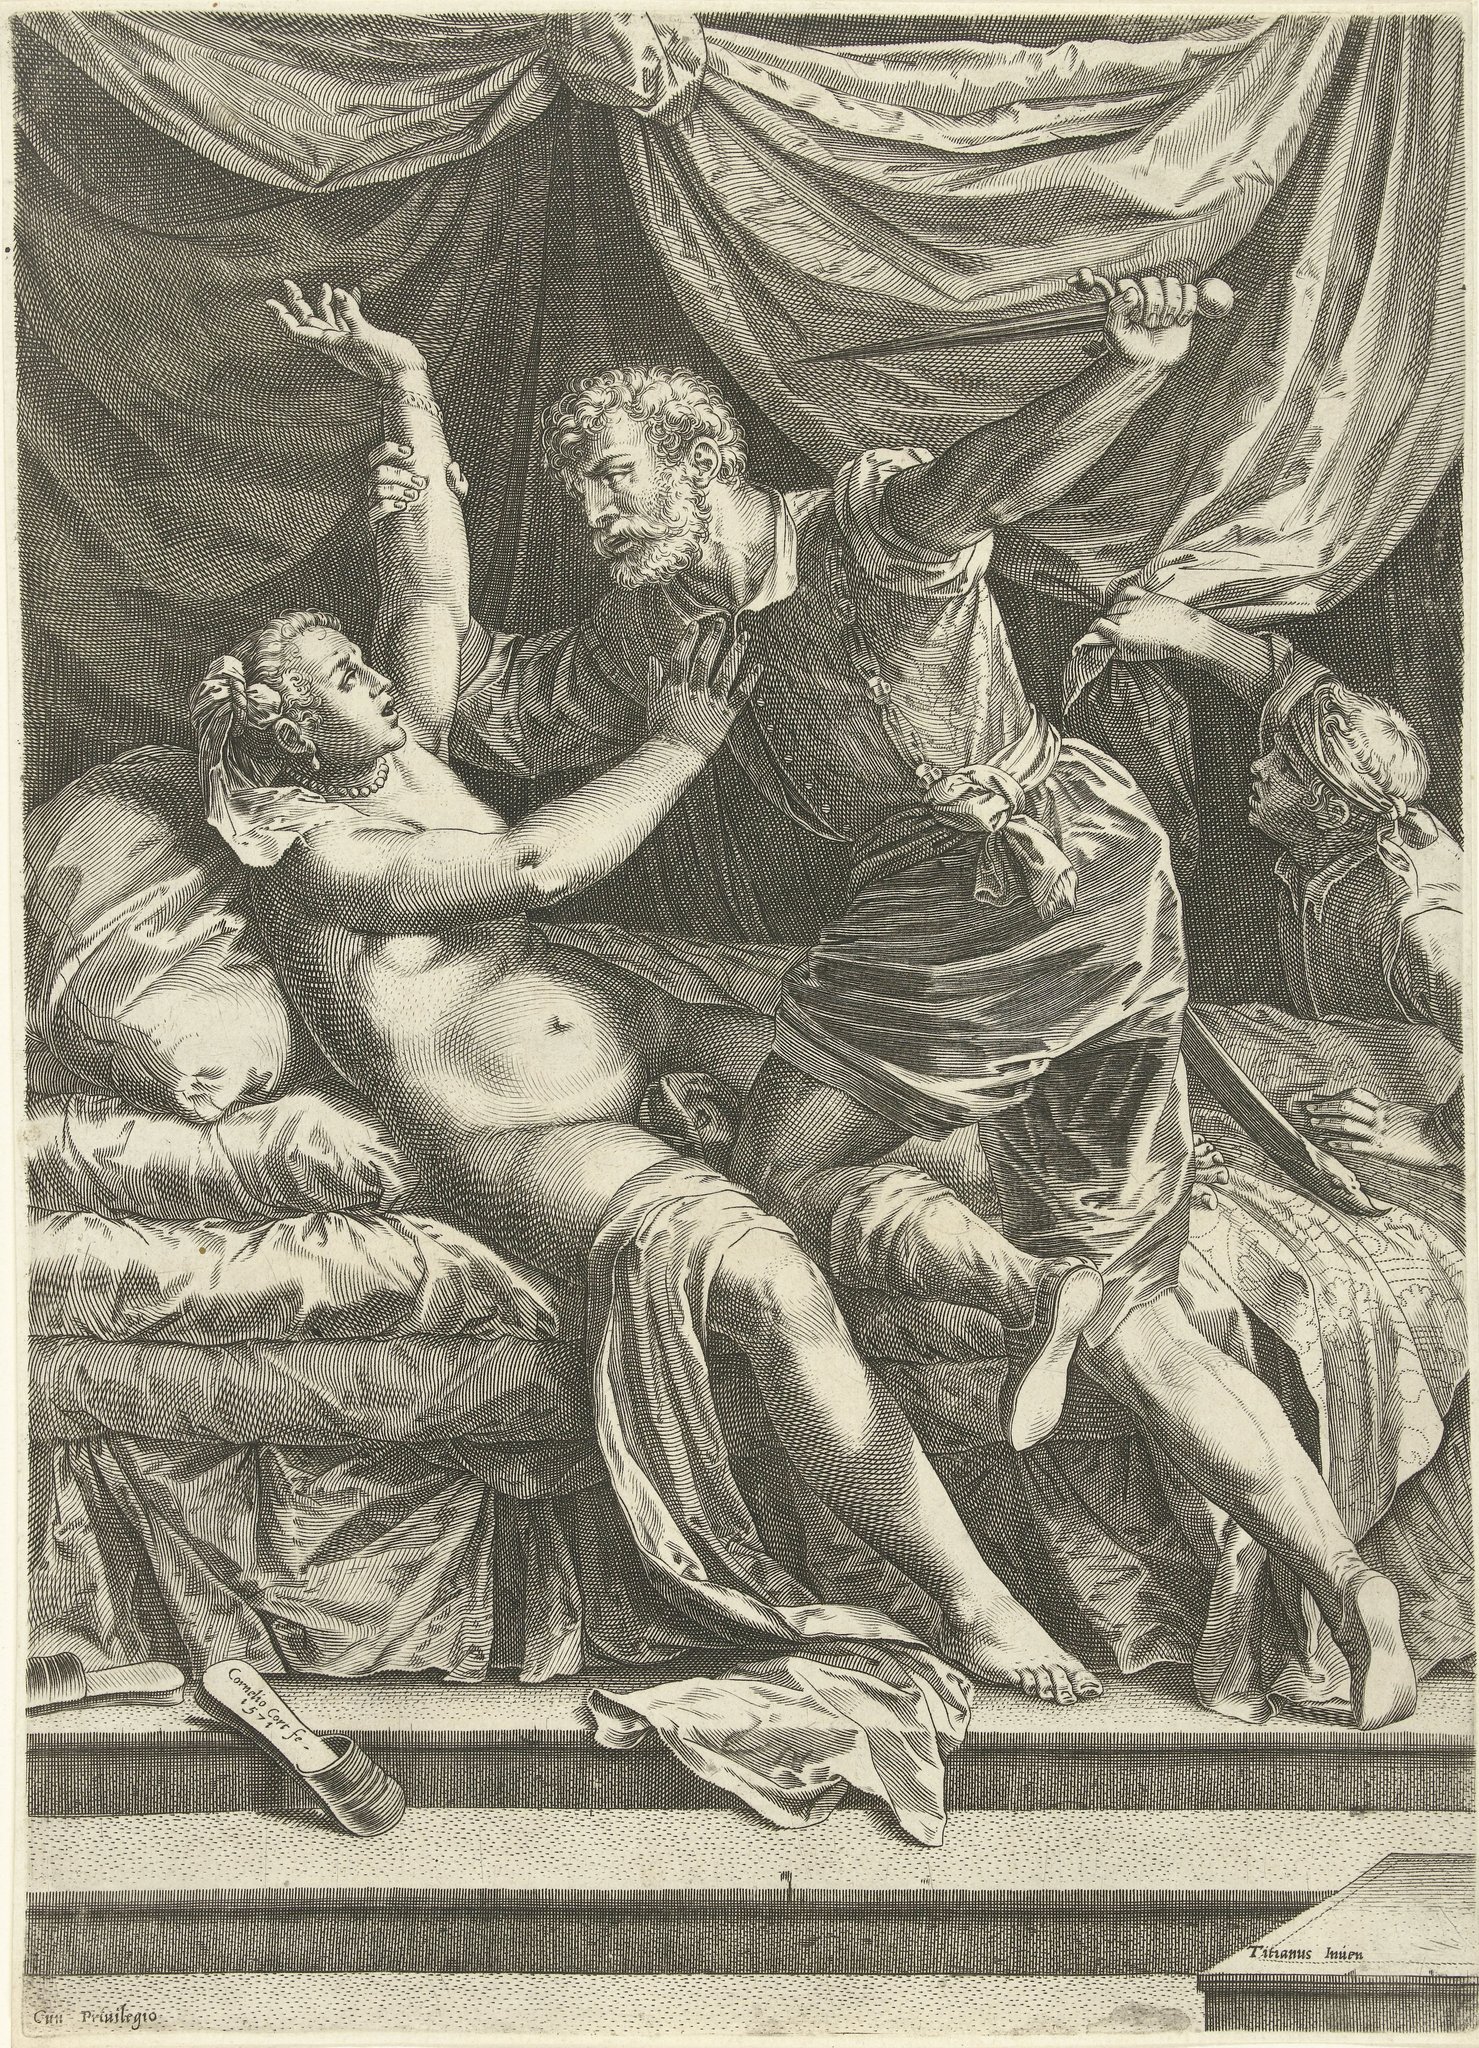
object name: print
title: Lucretia en Sextus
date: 1571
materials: paper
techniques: engraving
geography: rome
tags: (story of) lucretia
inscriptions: collector's mark: Lugt 2228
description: Sextus valt Lucretia, die naakt op een hemelbed ligt, aan met een dolk en dwingt haar zich aan hem te onderwerpen.